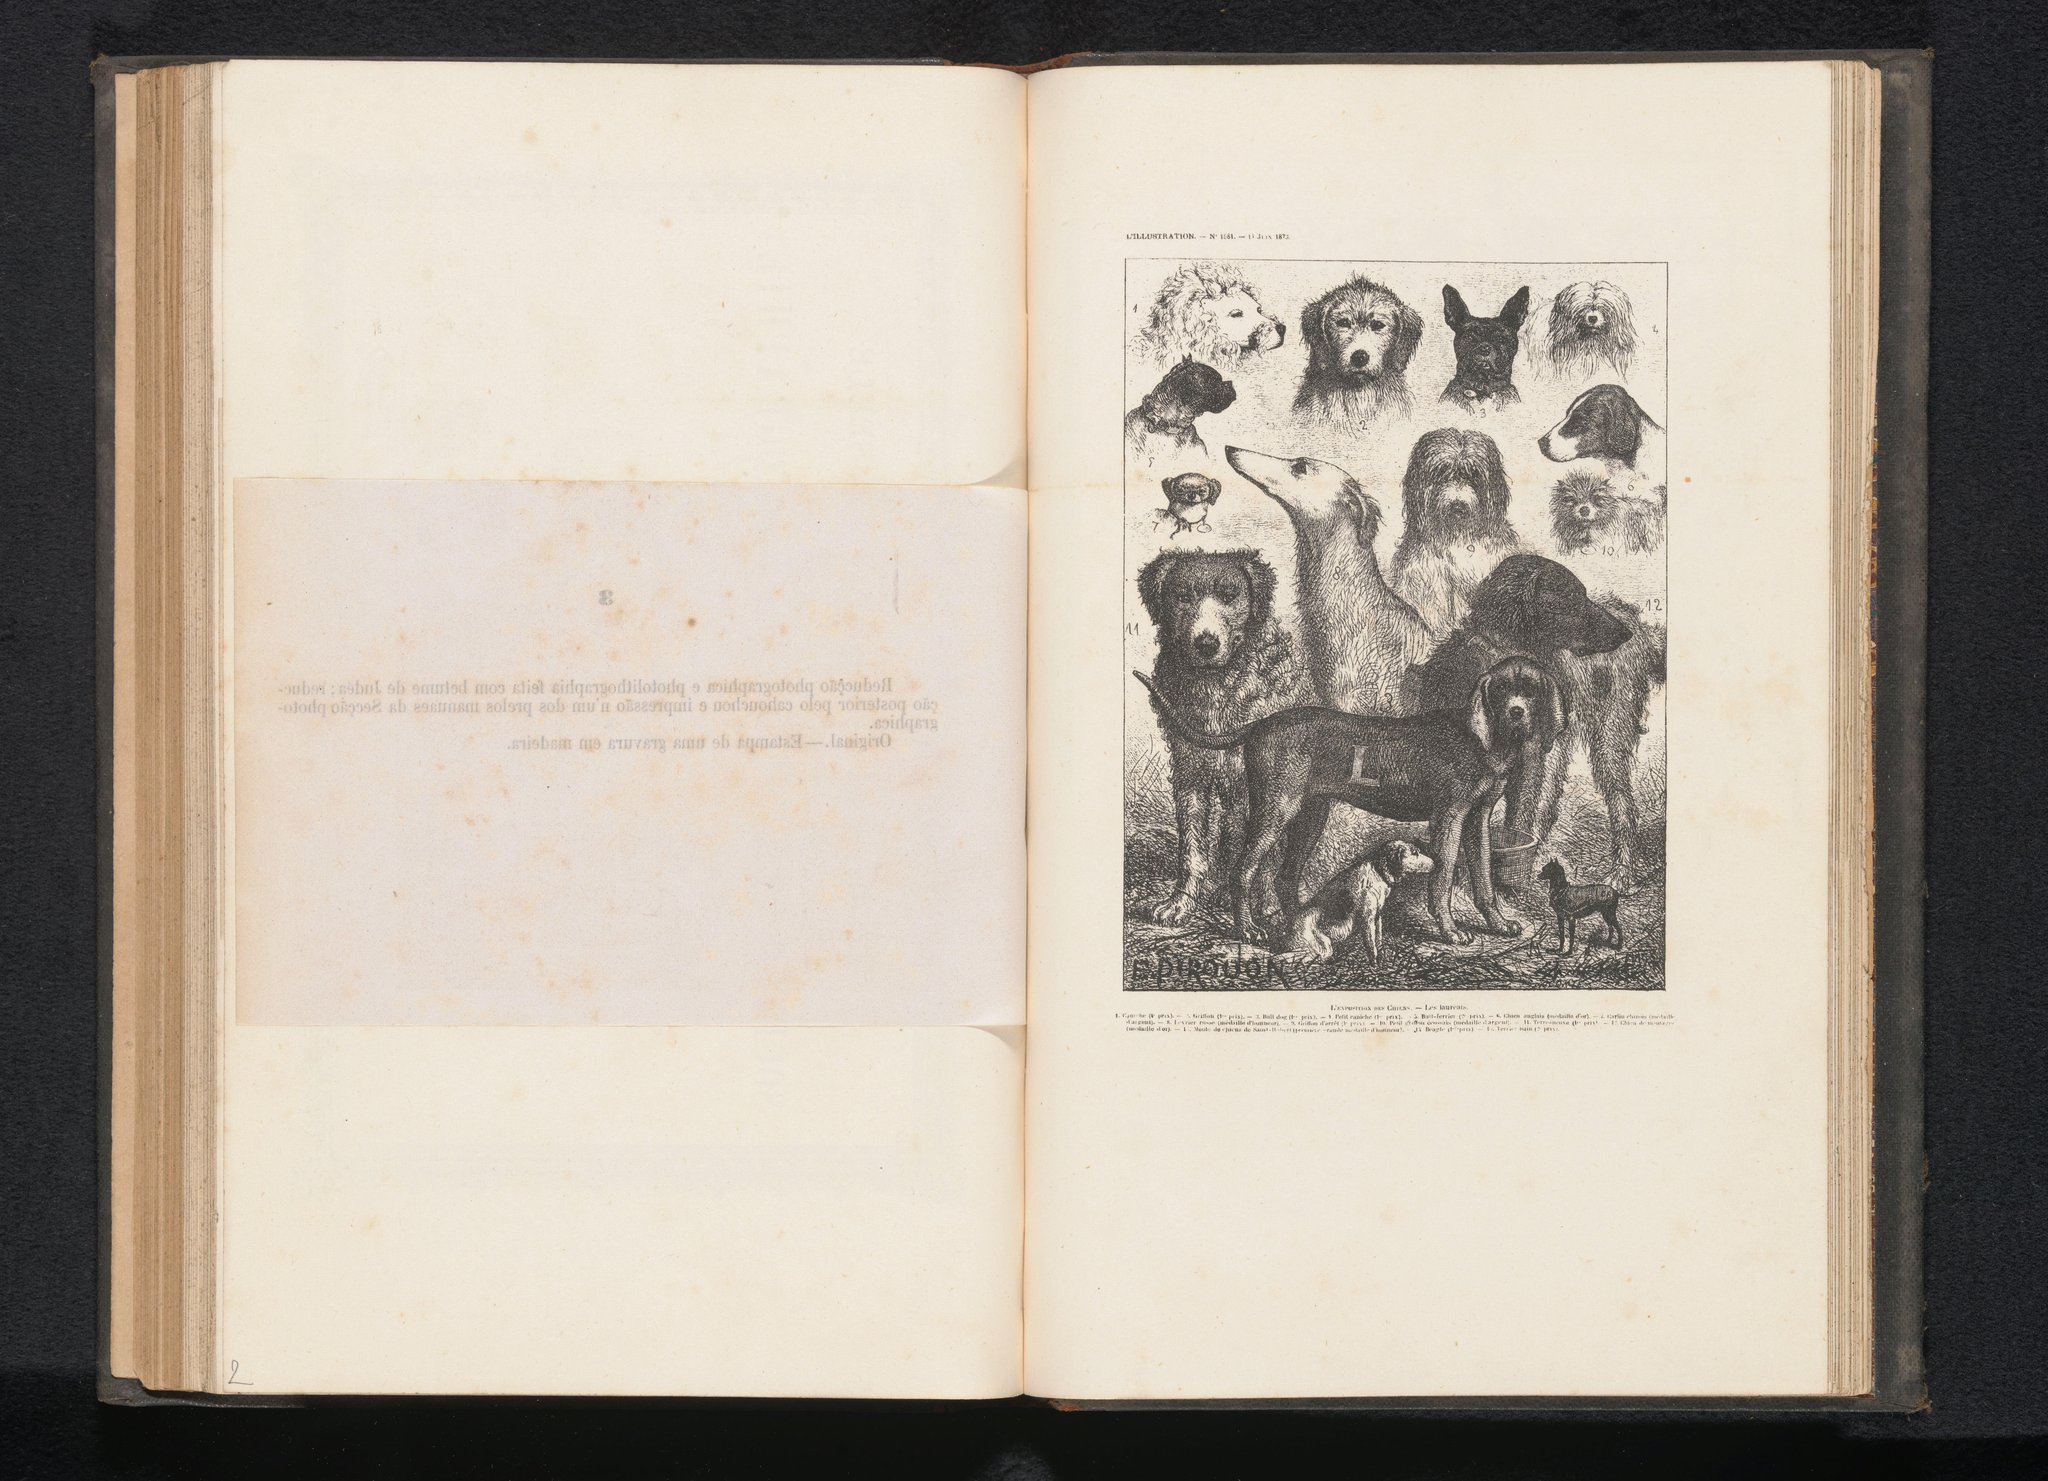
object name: photomechanical print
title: Fotoreproductie van een prent, voorstellende verschillende hondenrassen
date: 1866-1876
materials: paper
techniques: photolithography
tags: dog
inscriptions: number: ‘3’